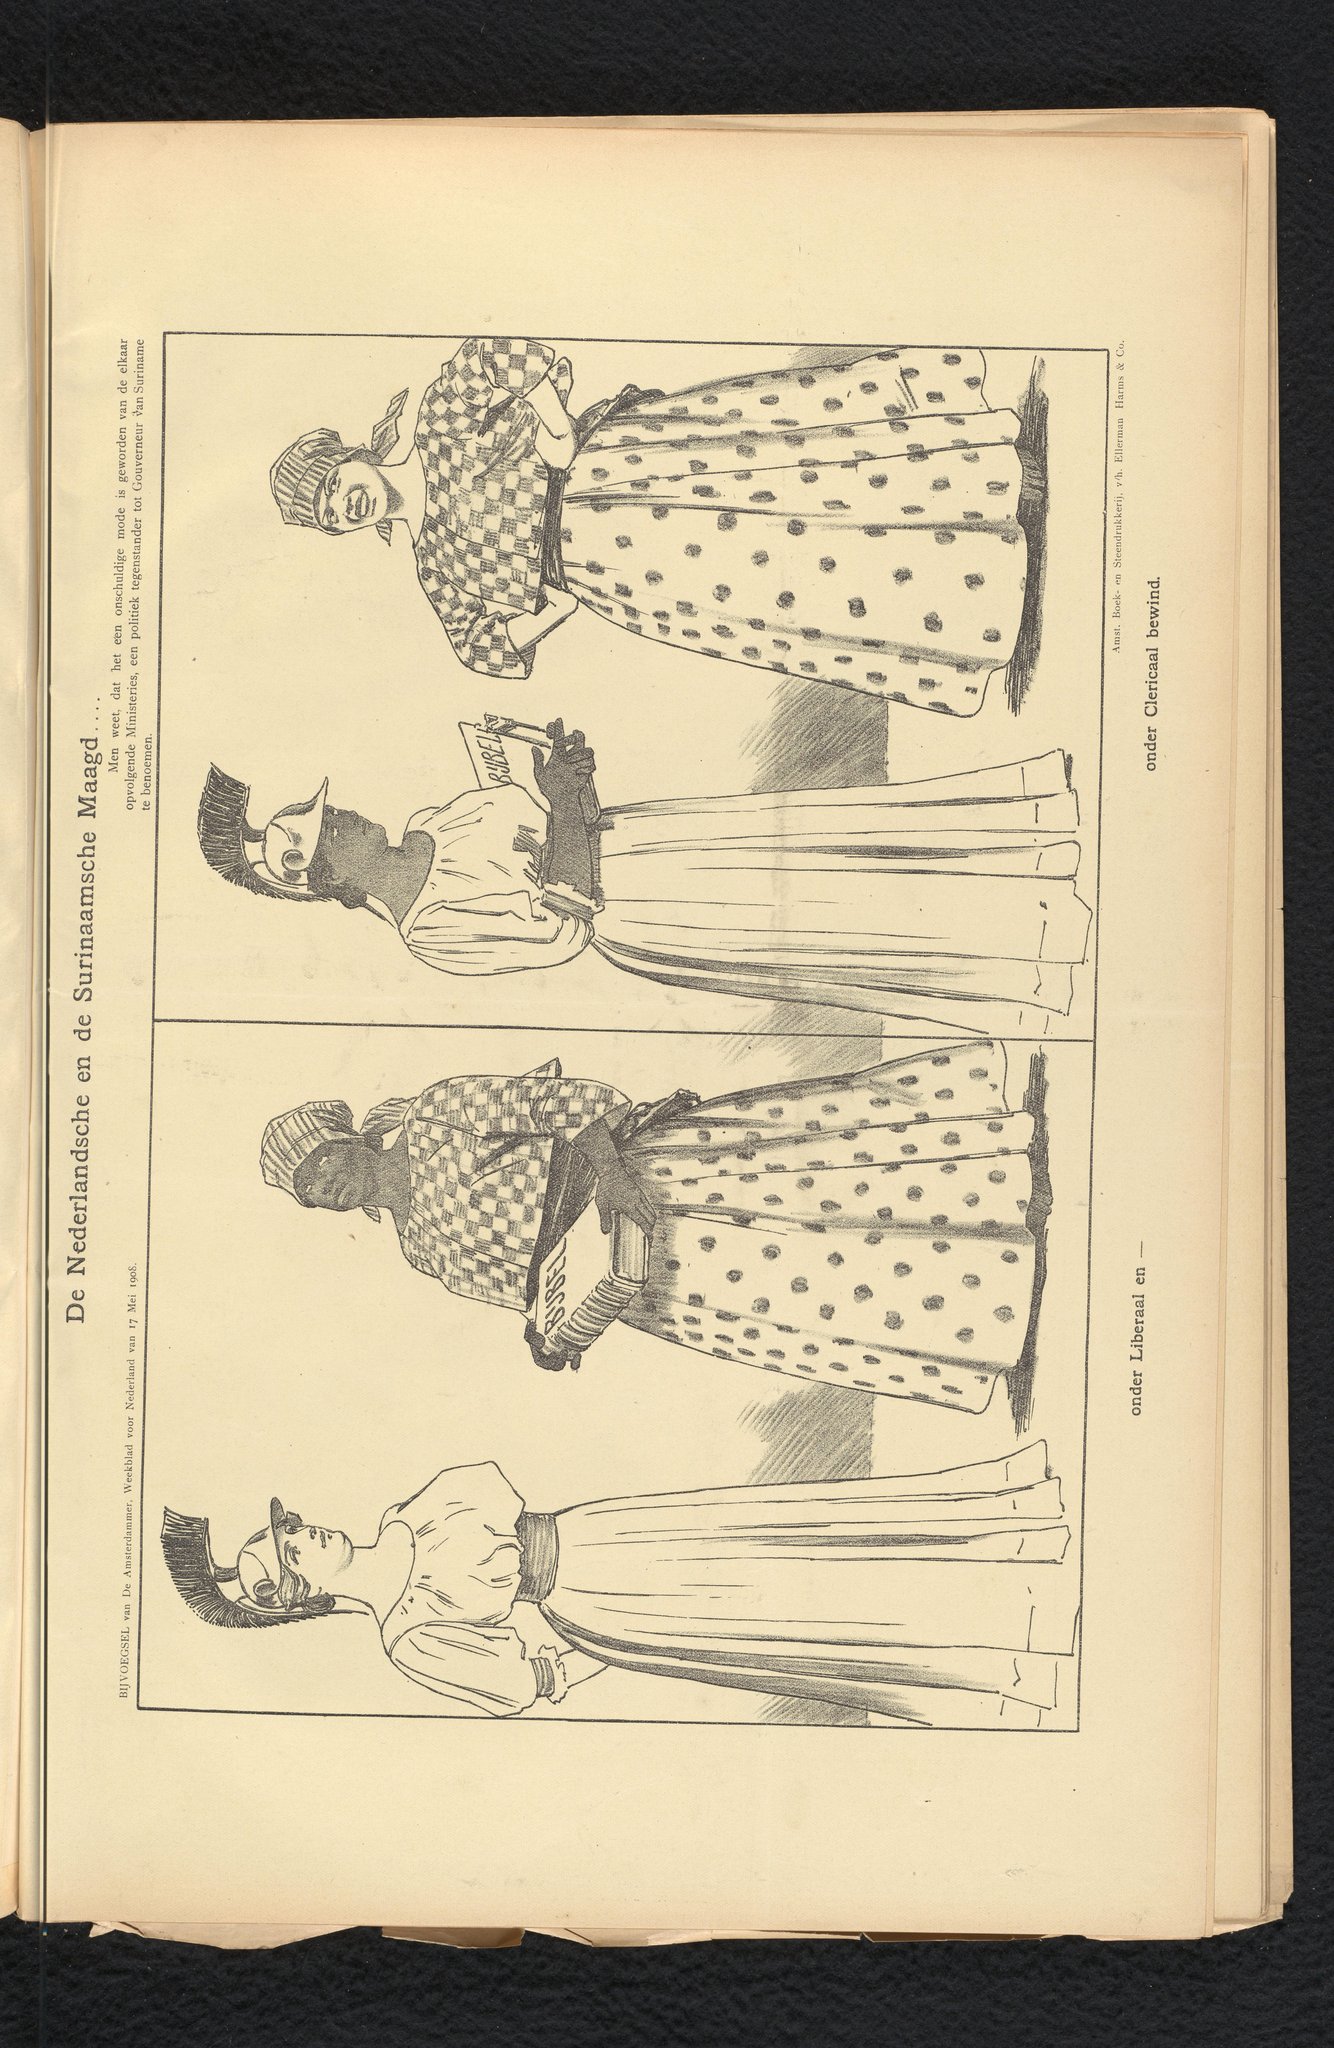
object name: cartoon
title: De Nederlandsche en de Surinaamsche Maagd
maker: johan braakensiek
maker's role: draughtsman, print maker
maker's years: 1858-1940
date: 1908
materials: paper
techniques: lithograph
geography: netherlands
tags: colonial governor, personifications of countries, nations, states, districts, etc., the bible as a book, political caricatures and satires, suriname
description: Twee voorstellingen van de Nederlandse en de Surinaamse Maagd, wisselend van huidskleur en afwisselend met de bijbel in de handen.